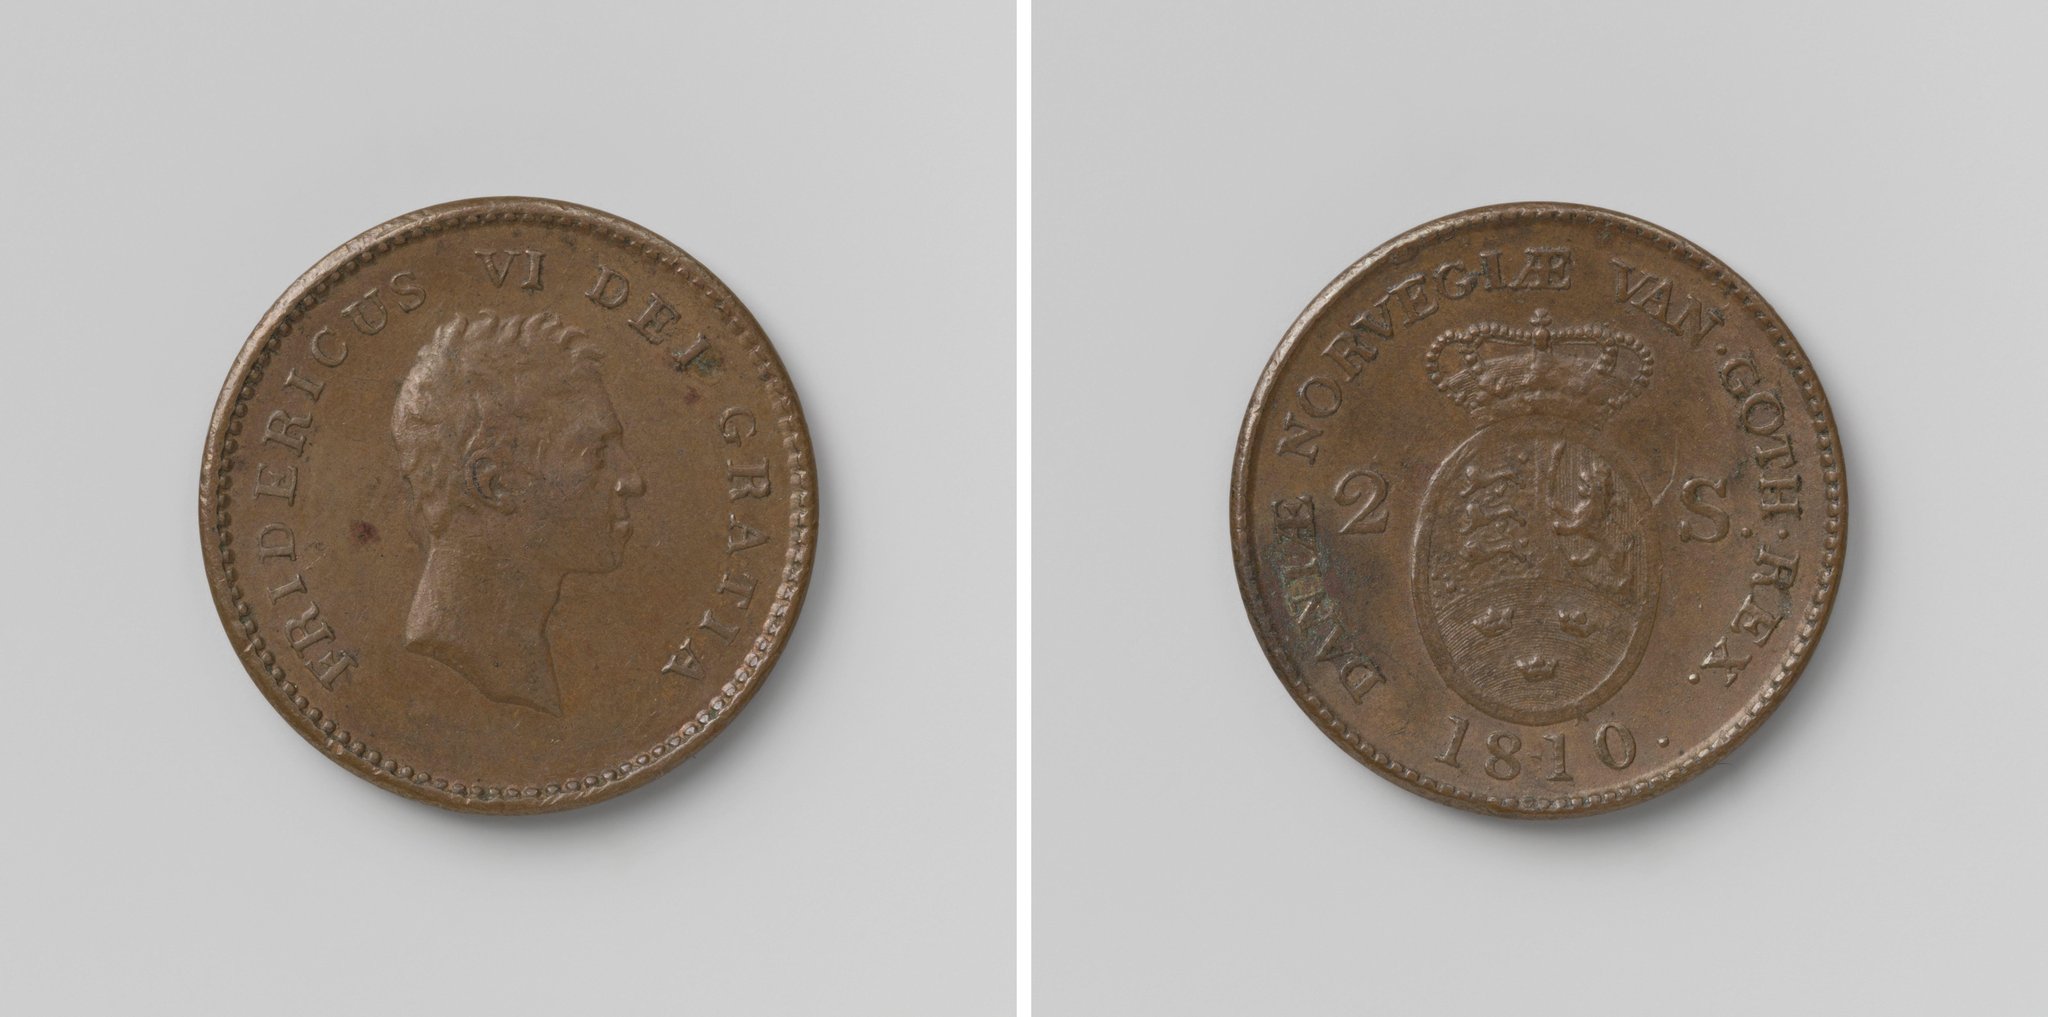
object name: coin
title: Frederik VI, koning van Denemarken, noodmunt van twee skilling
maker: Anonymous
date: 1810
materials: copper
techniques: striking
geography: denmark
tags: copenhagen (city)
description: Voorzijde: borststuk man binnen omschrift. Keerzijde: gekroond wapenschild tussen waardeaanduiding binnen omschrift